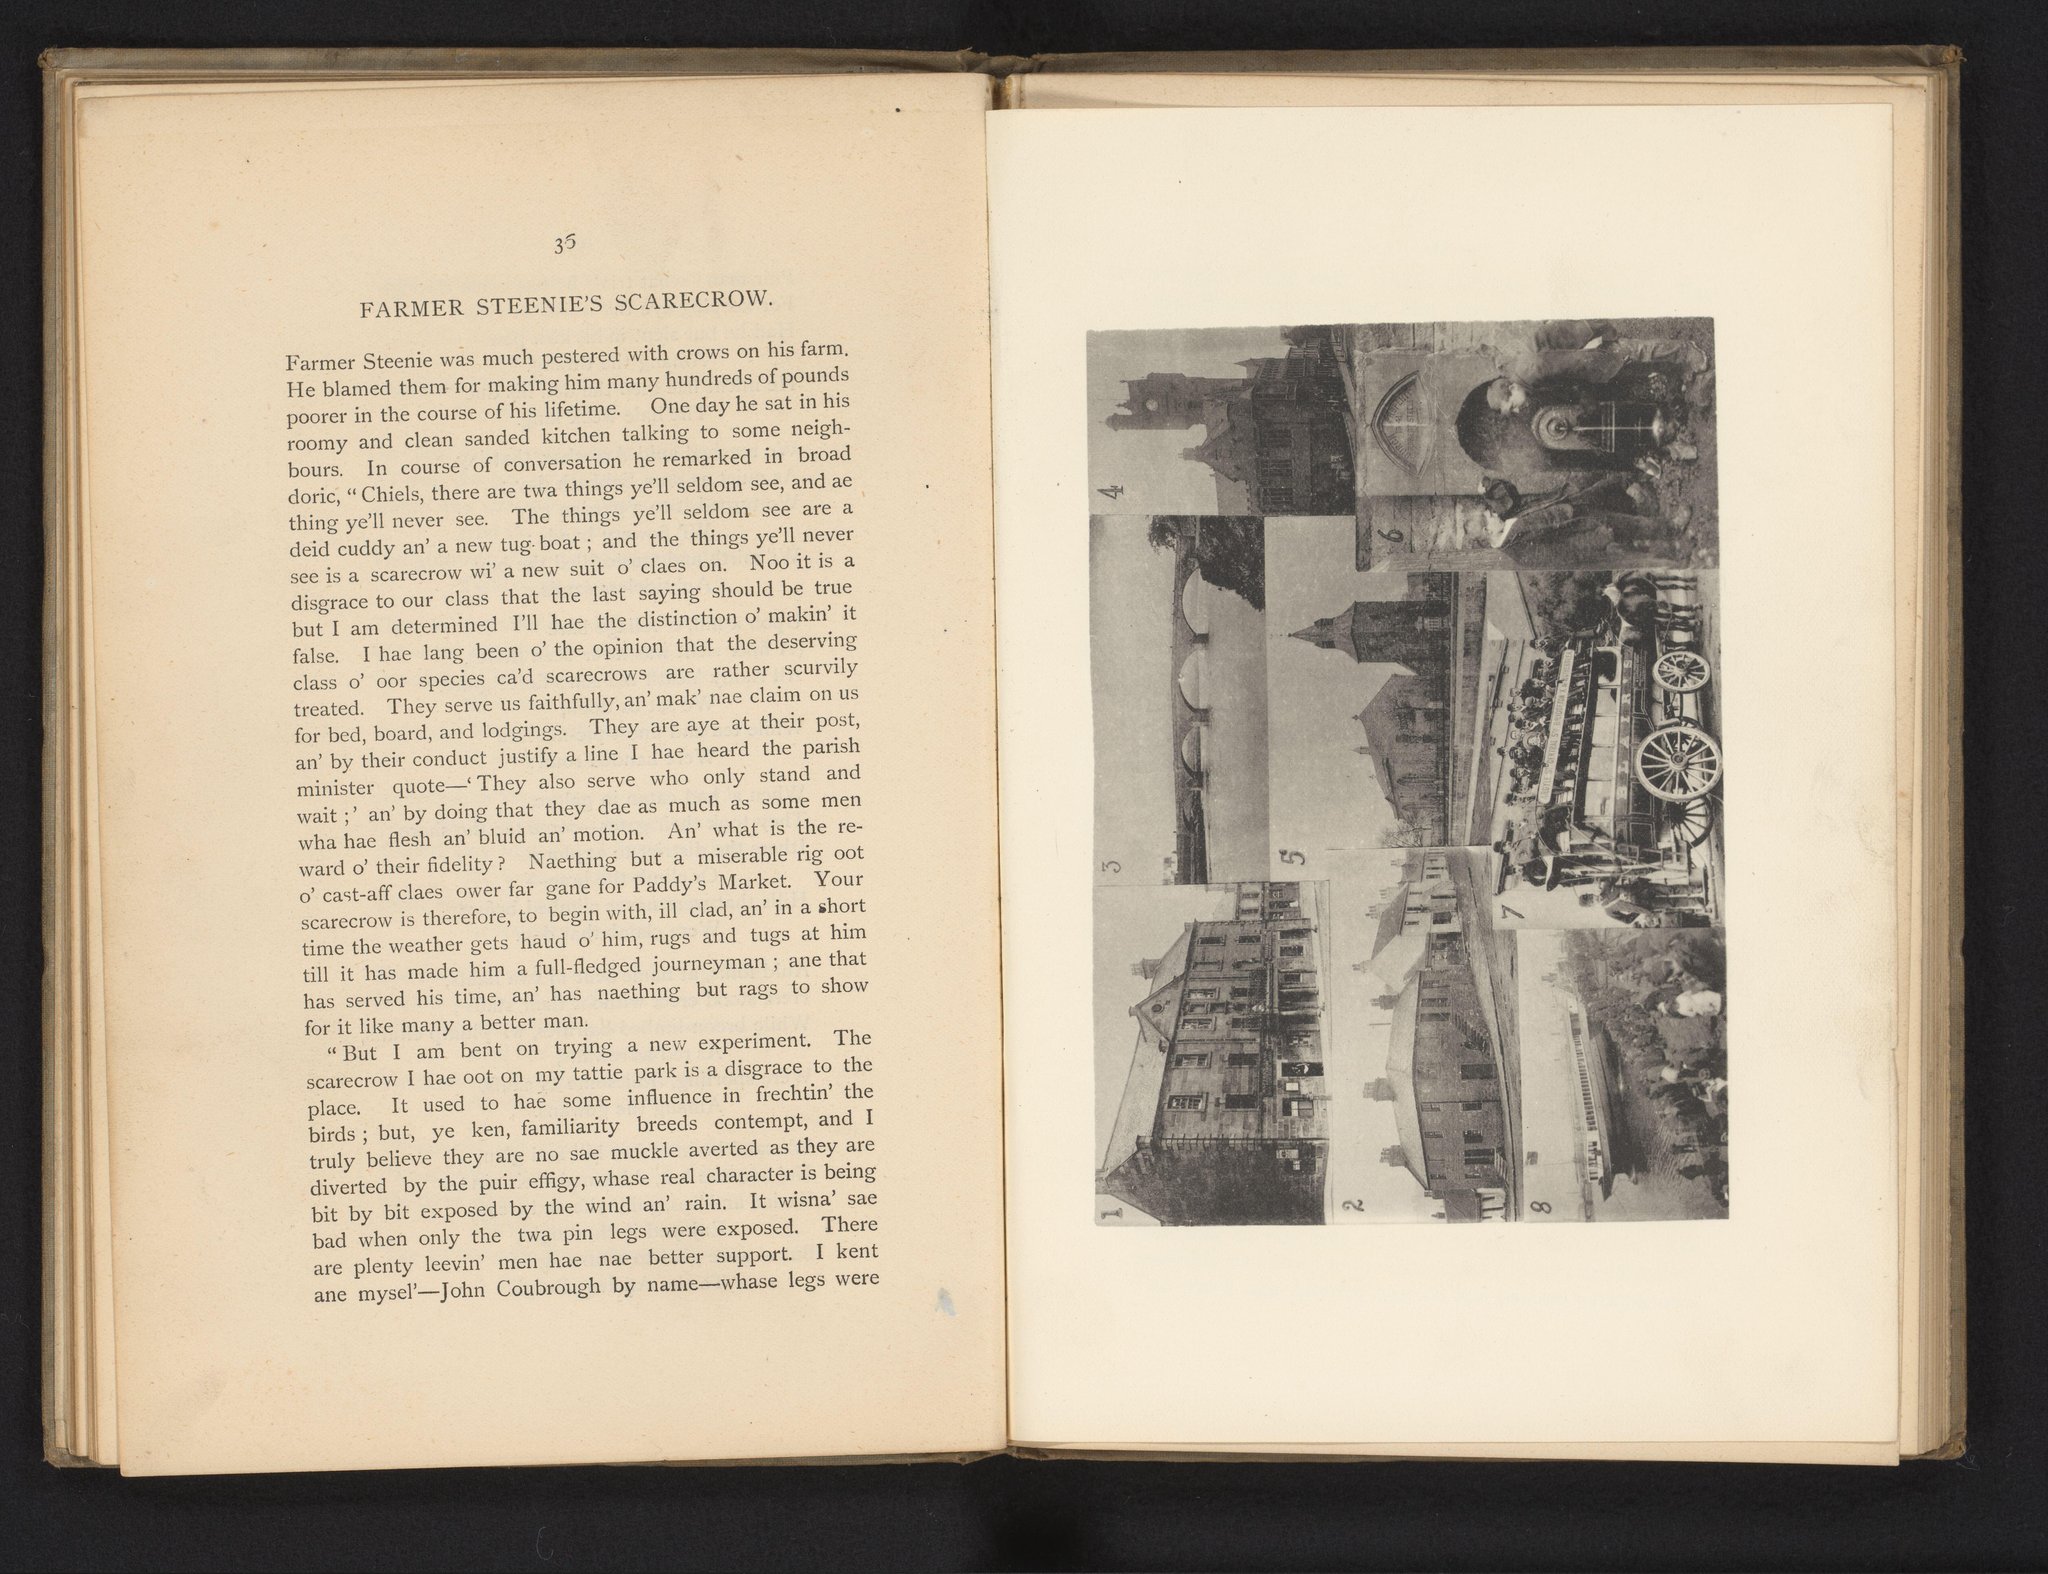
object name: page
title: Verzameling van beelden van Rutherglen met onder andere een paardentram, een brug, de haven en verschillende gebouwen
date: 1887-1892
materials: paper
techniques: photograph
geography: rutherglen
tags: four-wheeled, animal-drawn vehicle, e.g.: cab, carriage, coach, civic architecture; edifices; dwellings